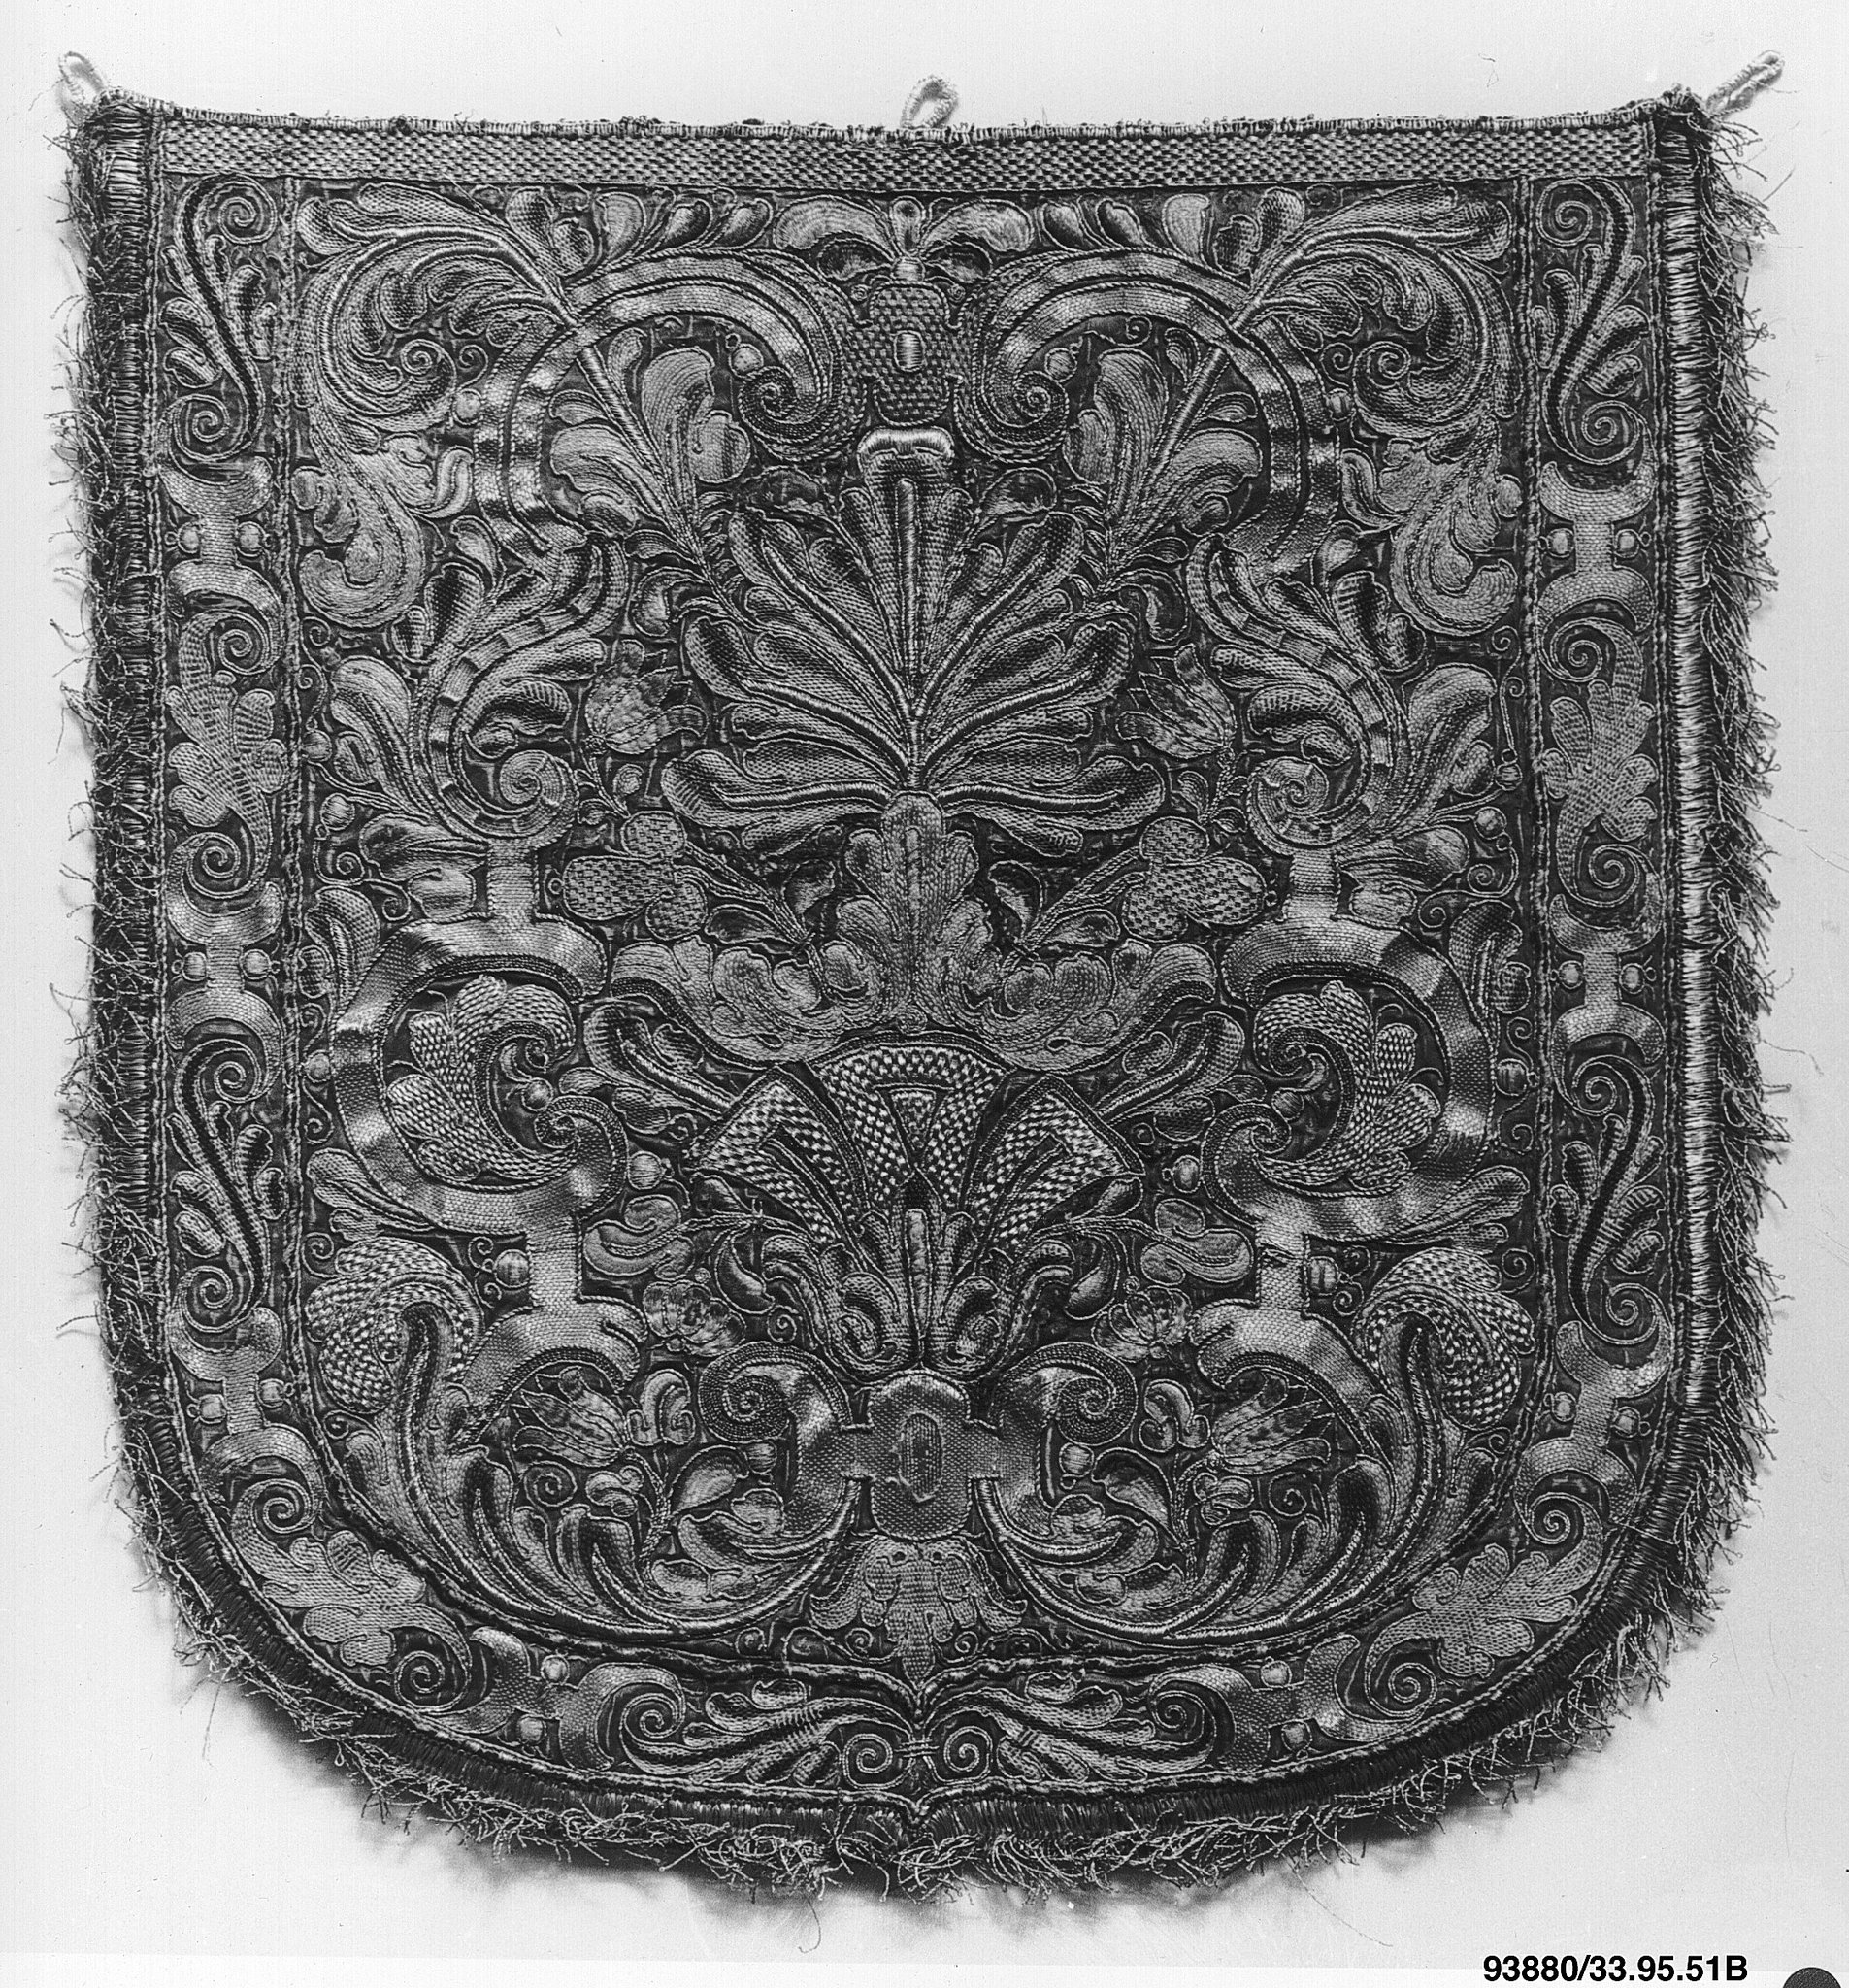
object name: hood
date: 1591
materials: metal thread, silk